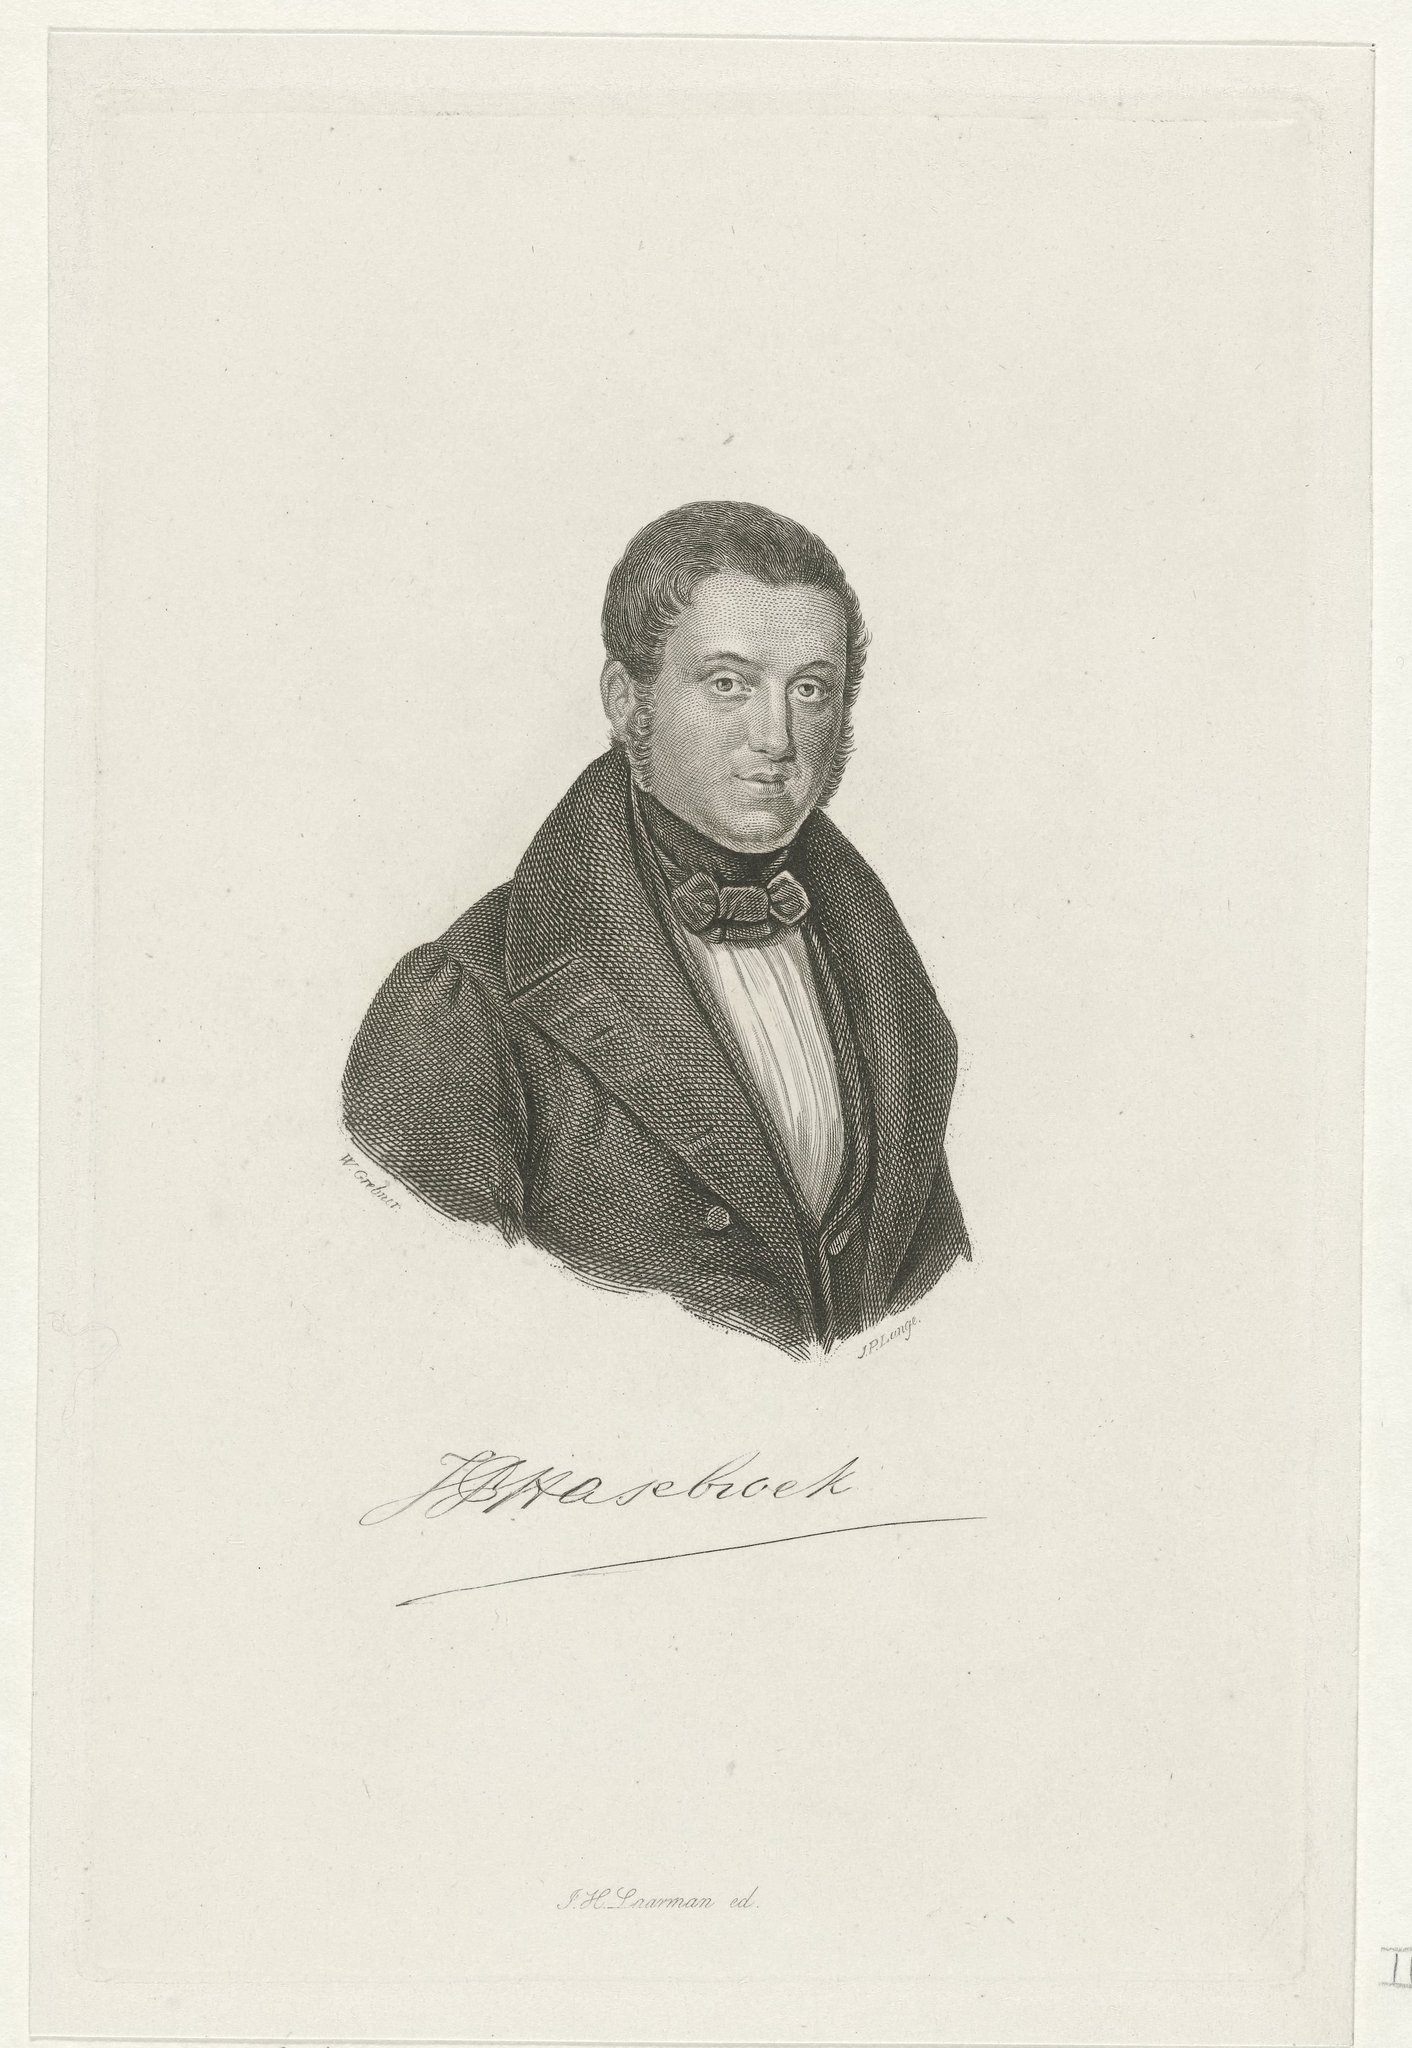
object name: print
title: Portret van Johannes Petrus Hasebroek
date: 1844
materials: paper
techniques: engraving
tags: leiden, amsterdam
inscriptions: collector's mark: Lugt 2228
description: Portretbuste naar rechts van Johannes Petrus Hasebroek, predikant te Heiloo, Breda, Middelburg en Amsterdam.